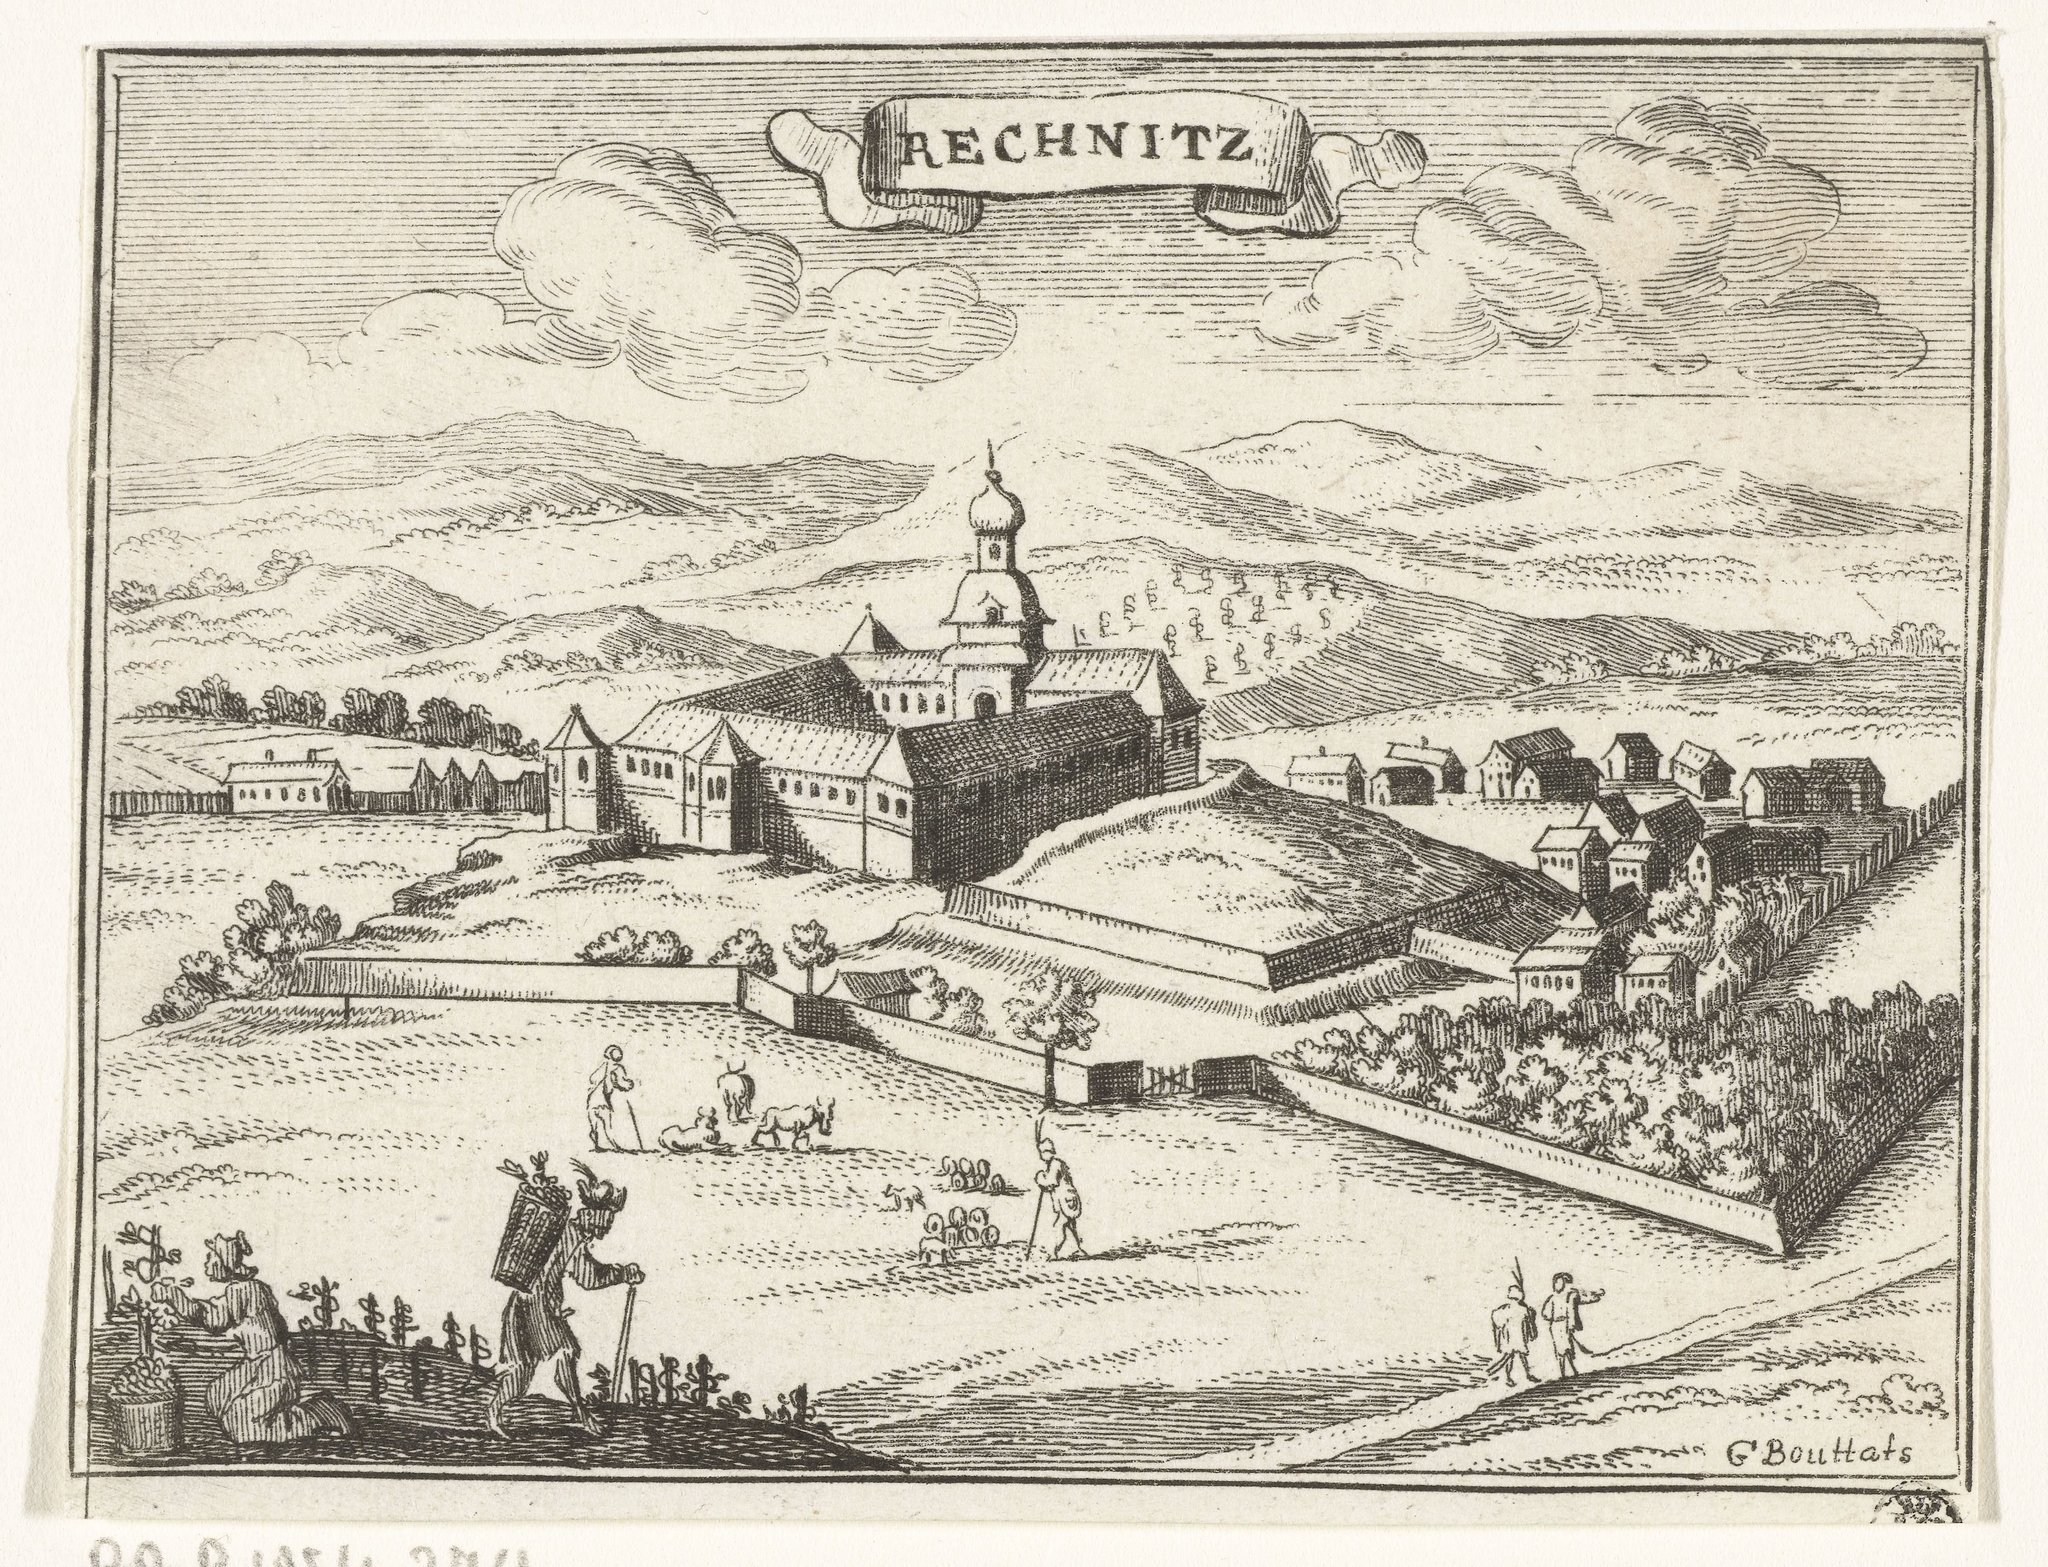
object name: print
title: Gezicht op Rechnitz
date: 1686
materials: paper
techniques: etching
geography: antwerp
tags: prospect of city, town panorama, silhouette of city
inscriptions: collector's mark: Lugt 2228, collector's mark: Lugt 2760, collector's mark: Lugt 971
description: illustriatie voor J. Peeters en C. Bouttats, "Korte beschryvinghe, en de aen-wysinghe der plaetsen in desen boeck, met hunnen teghen woordighen standt, pertinentelijk uyt-ghebeldt, in Oostenryck", Antwerpen 1686.